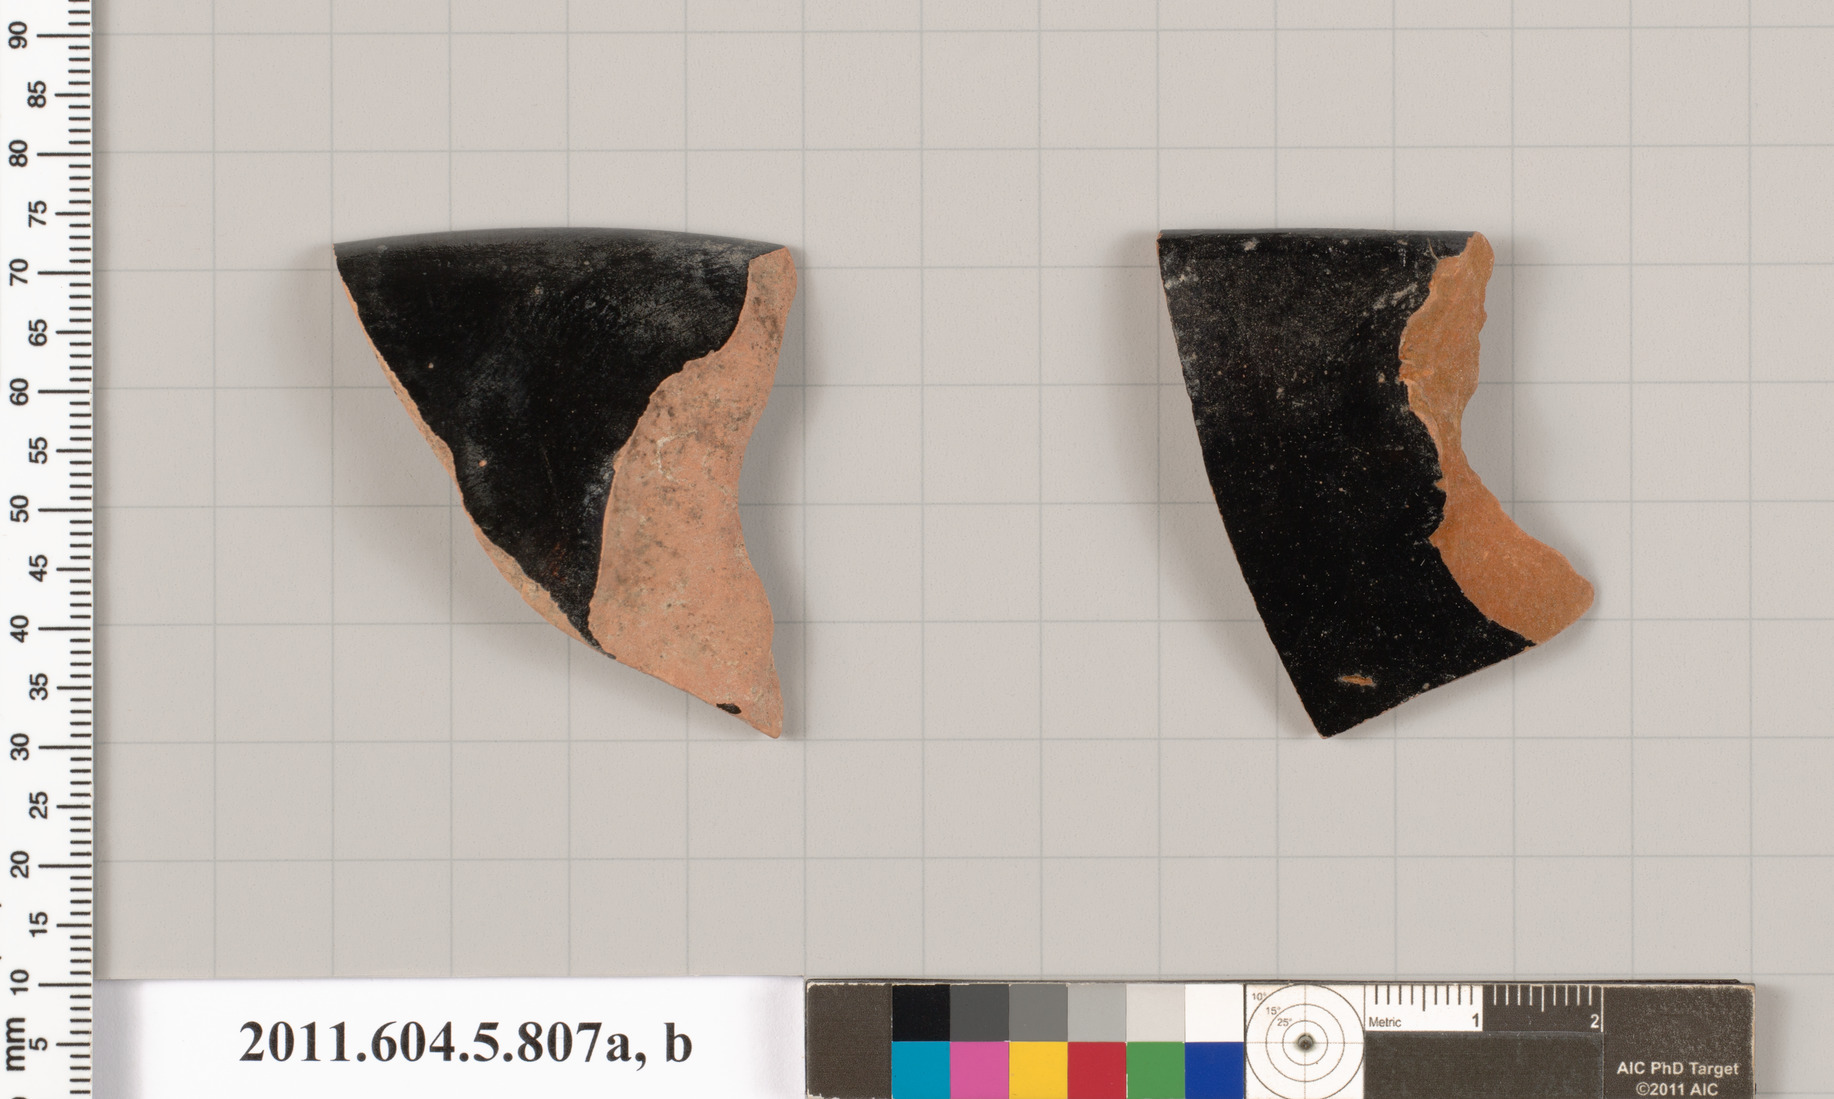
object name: kylix fragment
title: Terracotta rim fragments of kylikes (drinking cups)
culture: greek, attic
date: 600-401 BCE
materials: terracotta